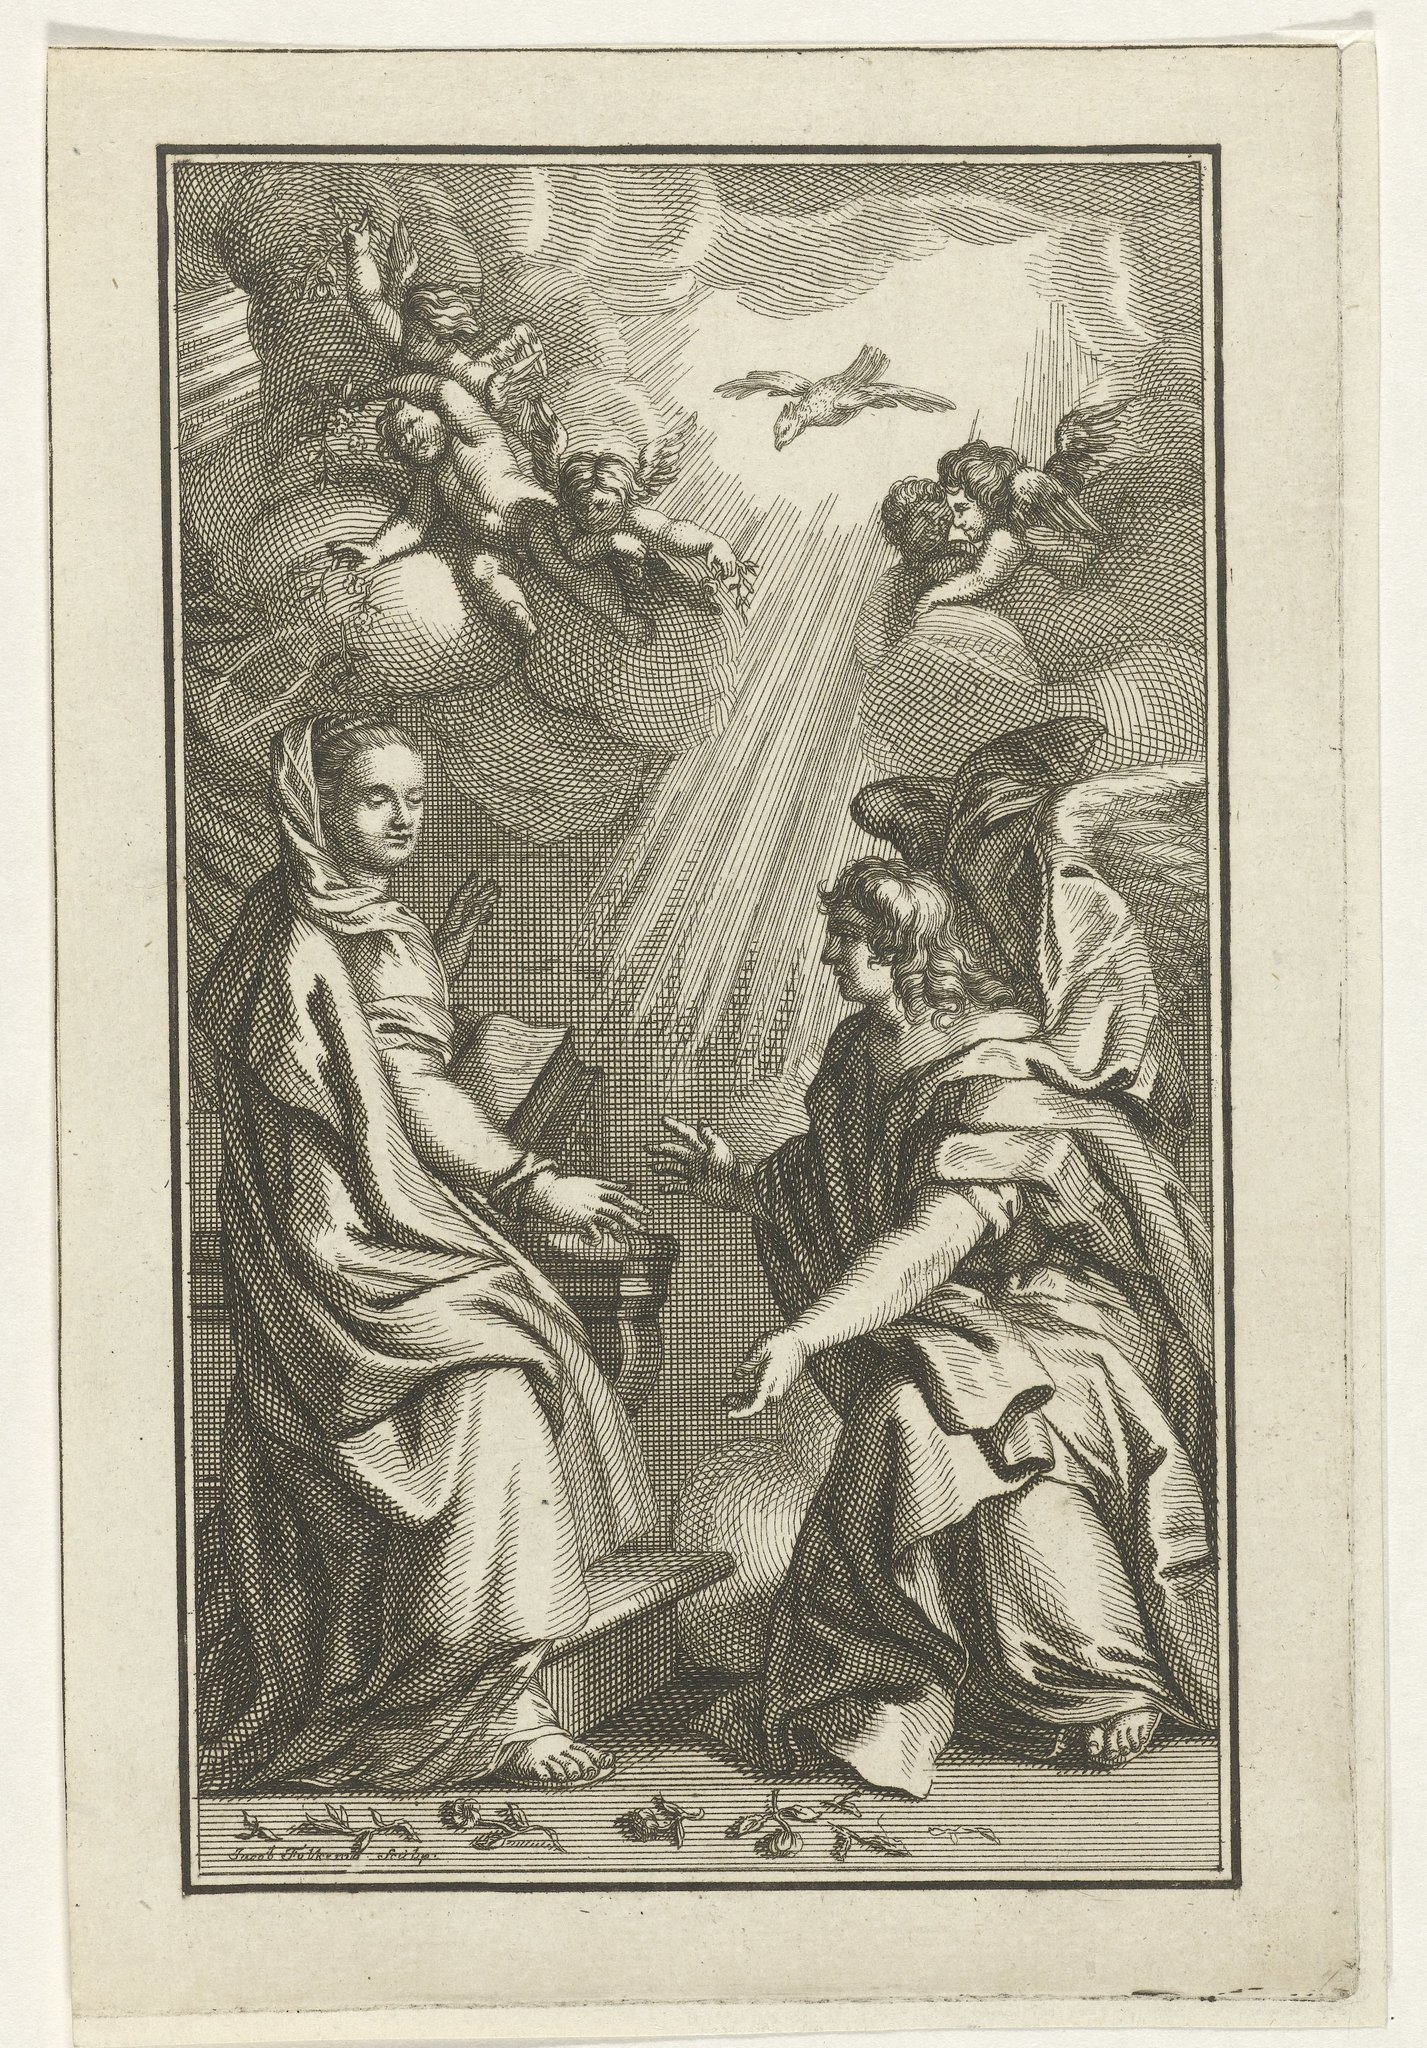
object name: print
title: De annunciatie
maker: jacob folkema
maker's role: draughtsman, print maker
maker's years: 1692-1767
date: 1702-1767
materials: paper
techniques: etching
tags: the annunciation: mary, usually reading, is visited by the angel (sometimes a woman overhears the conversation)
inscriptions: collector's mark: Lugt 240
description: Maria kijkt op van haar boek wanneer de engel Gabriël haar bezoekt om de geboorte van Christus aan te kondigen. In de lucht vliegt een duif, het christelijke symbool van de Heilige Geest, met links en rechts bloemen strooiende engeltjes.